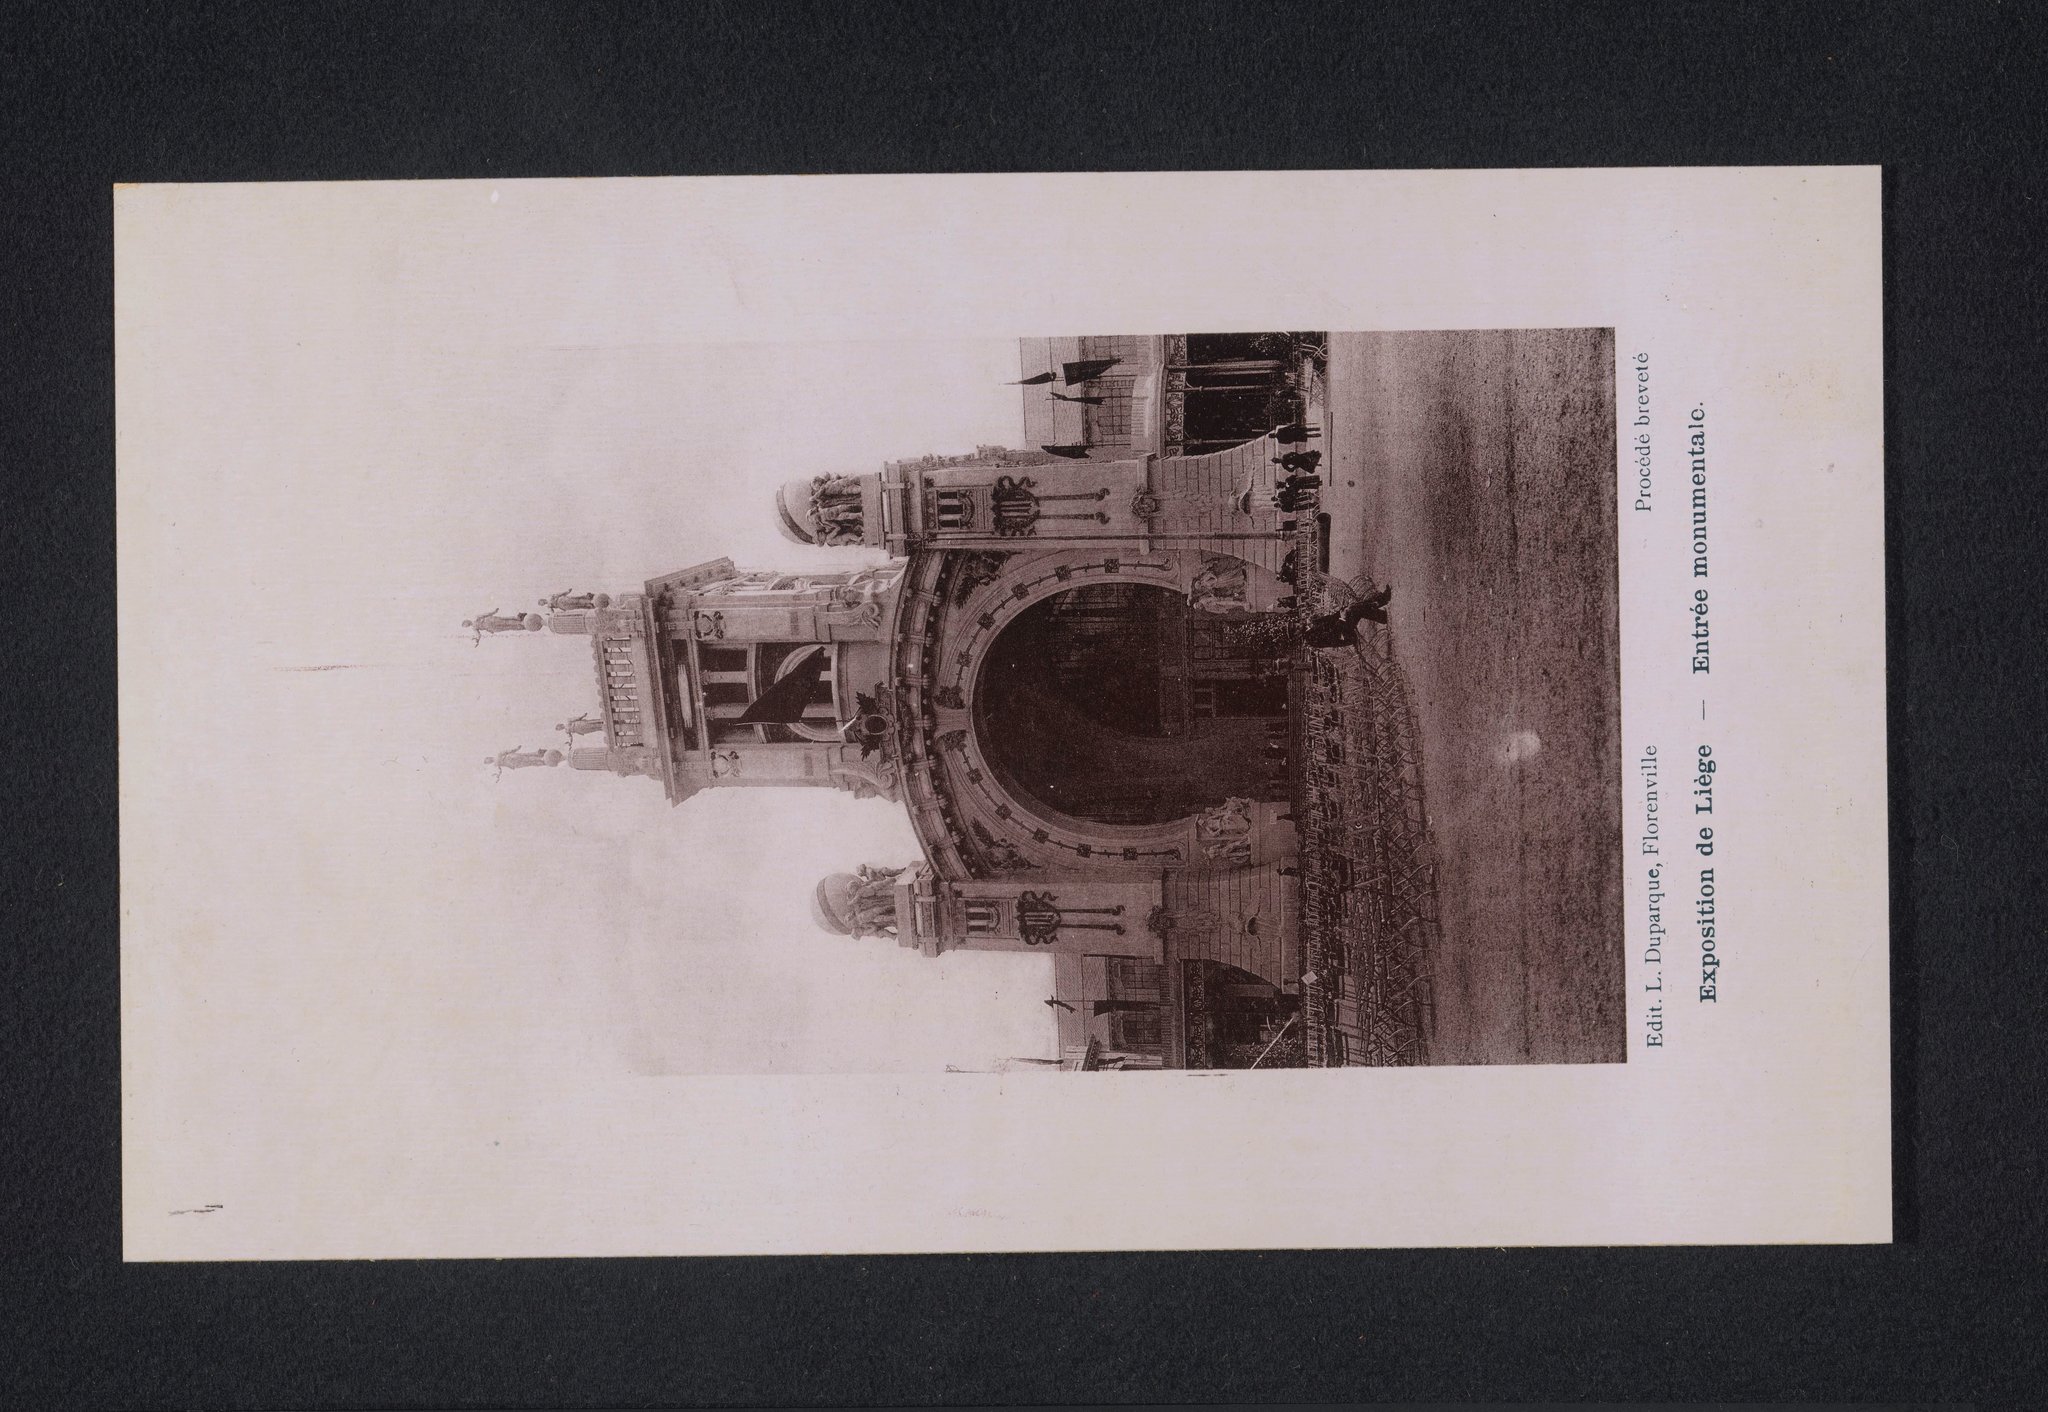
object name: photomechanical print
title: Exposition de Liège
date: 1905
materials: paper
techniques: photograph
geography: florenville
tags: world fair, world exhibition, gate, entrance, liège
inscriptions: inscription: ‘Procédé breveté’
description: Deze prent maakt deel uit van een omslag met 16 prenten.